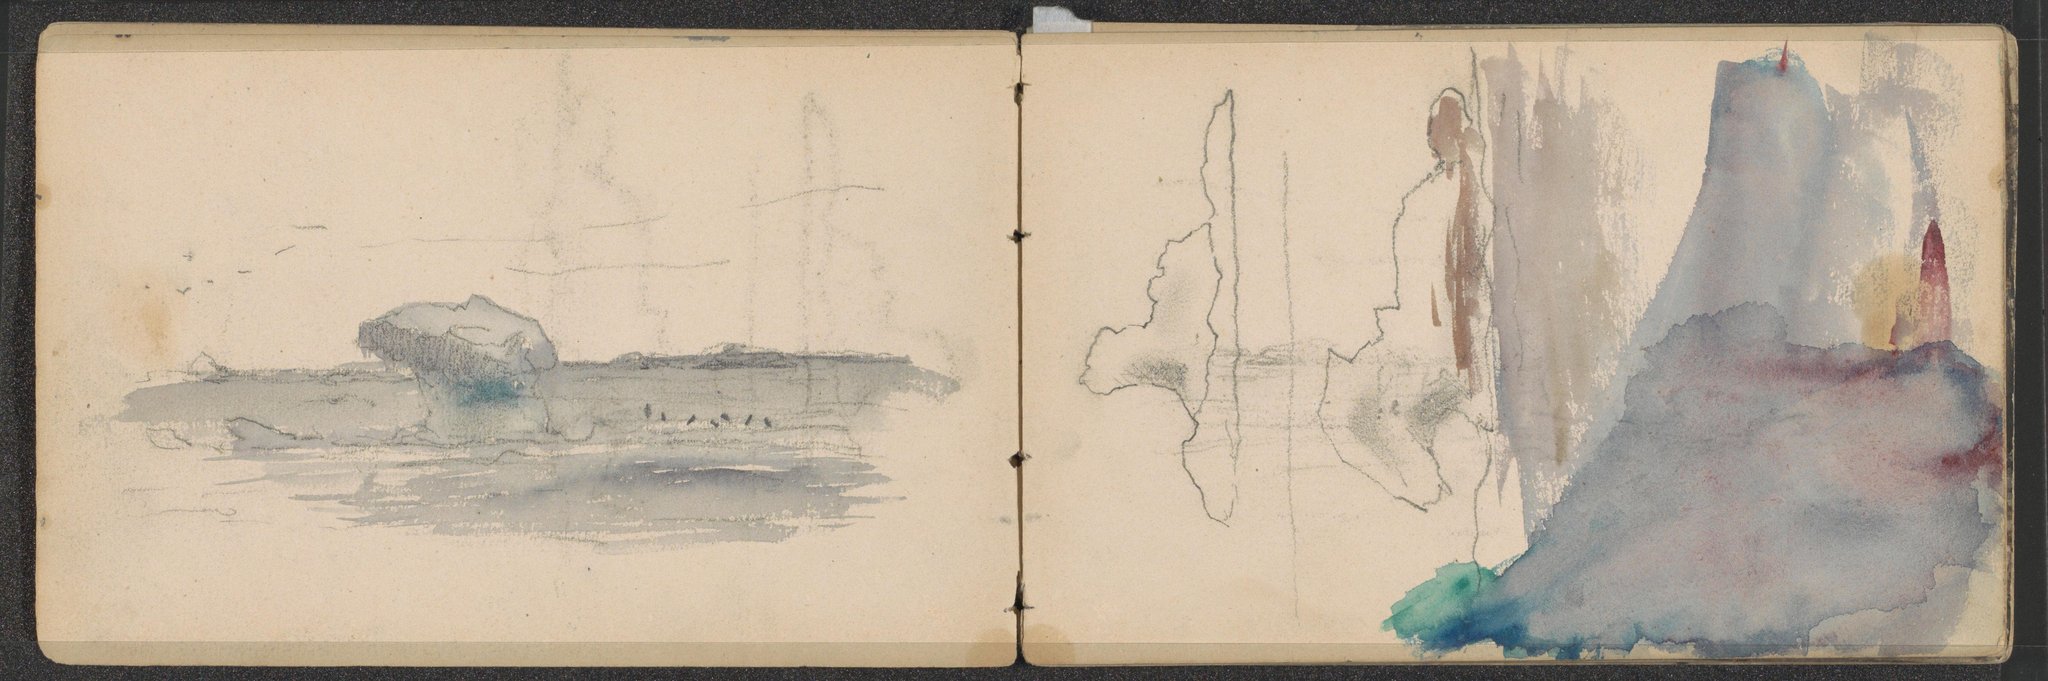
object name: sketchbook leaf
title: Gezicht op de Barentszzee met ijsschotsen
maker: louis apol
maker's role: draughtsman, painter, print maker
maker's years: 1850-1936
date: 1880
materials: chalk, paper, watercolor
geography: barentsz sea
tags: iceberg, sea (seascape), drift ice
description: Blad 6 verso uit een schetsboek met 35 bladen betekend tijdens de expeditie naar Nova Zembla in 1880.